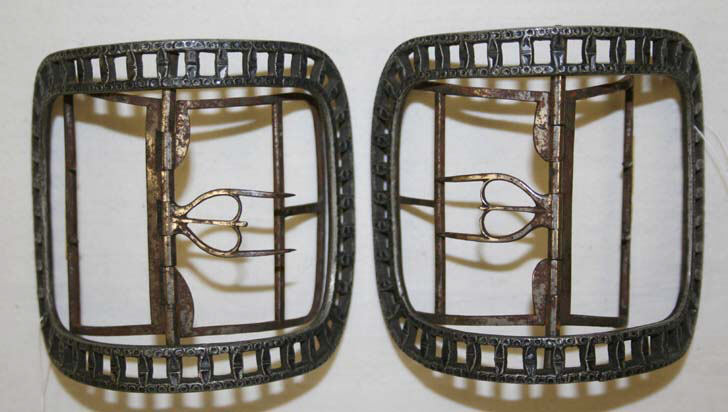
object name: shoe buckle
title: Shoe buckles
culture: european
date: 1767-1800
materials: metal